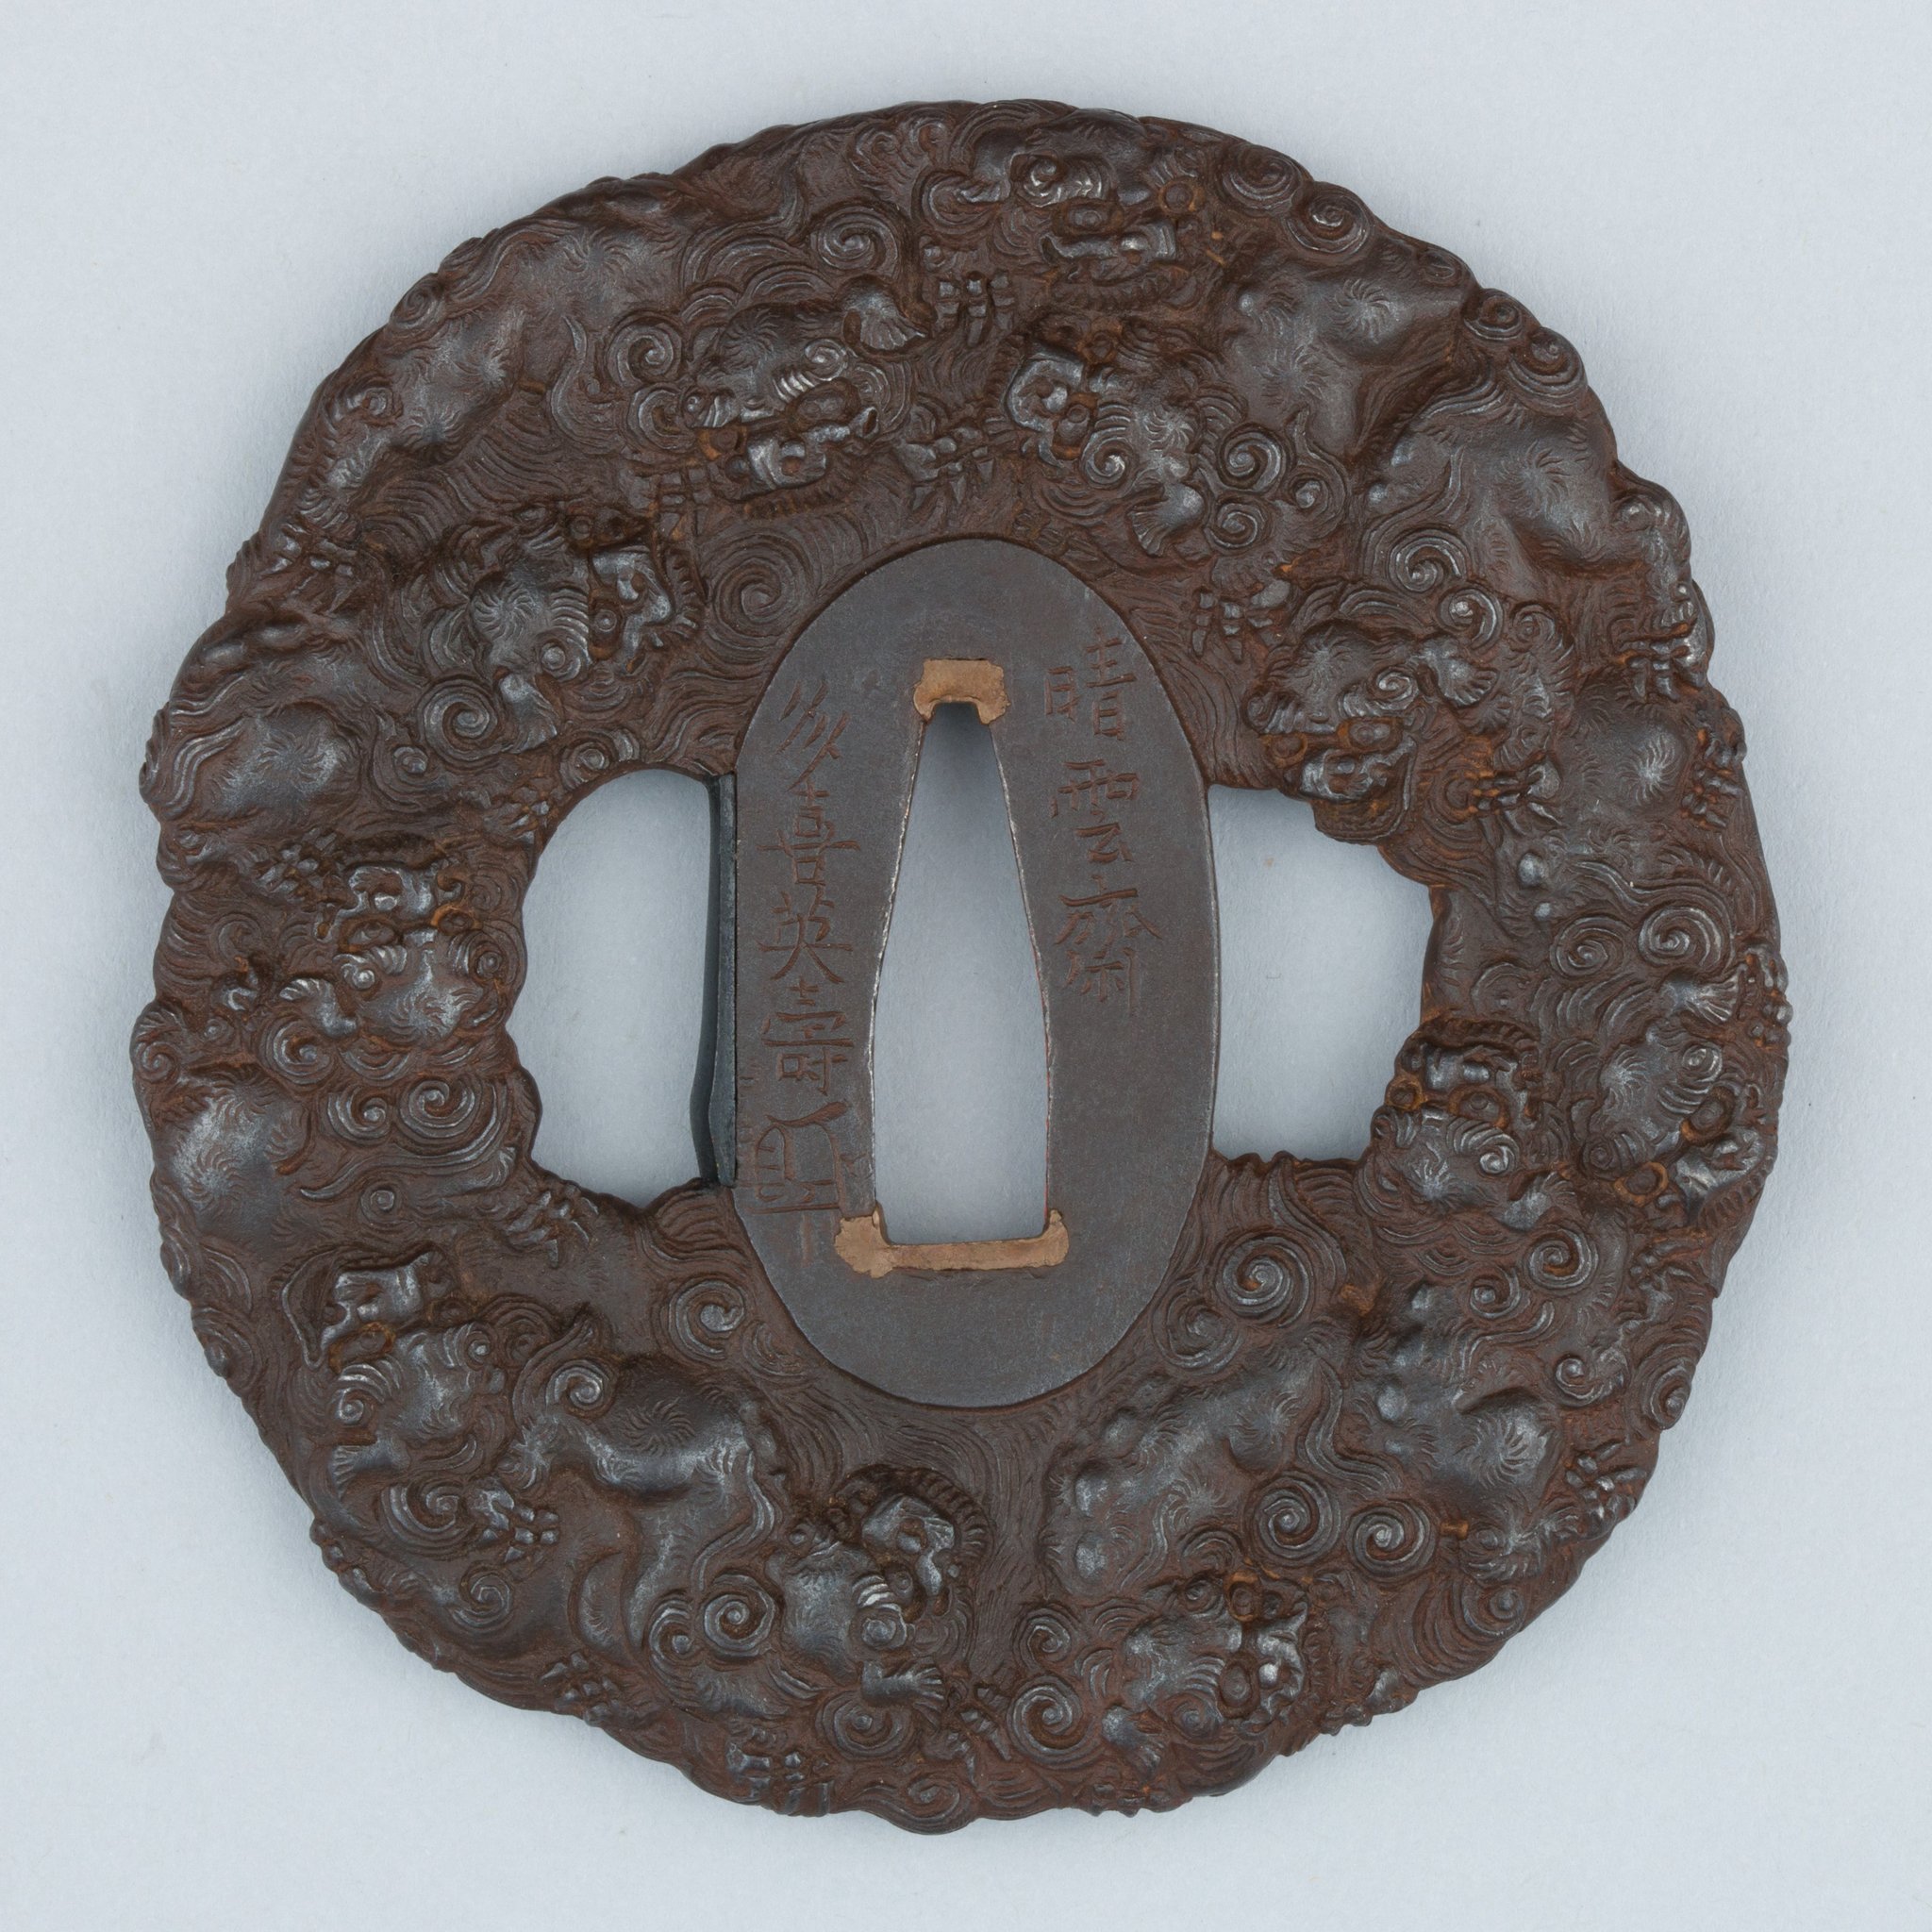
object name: sword guard tsuba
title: Sword Guard (Tsuba)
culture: japanese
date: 1615-1868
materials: copper, iron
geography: japan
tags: lions